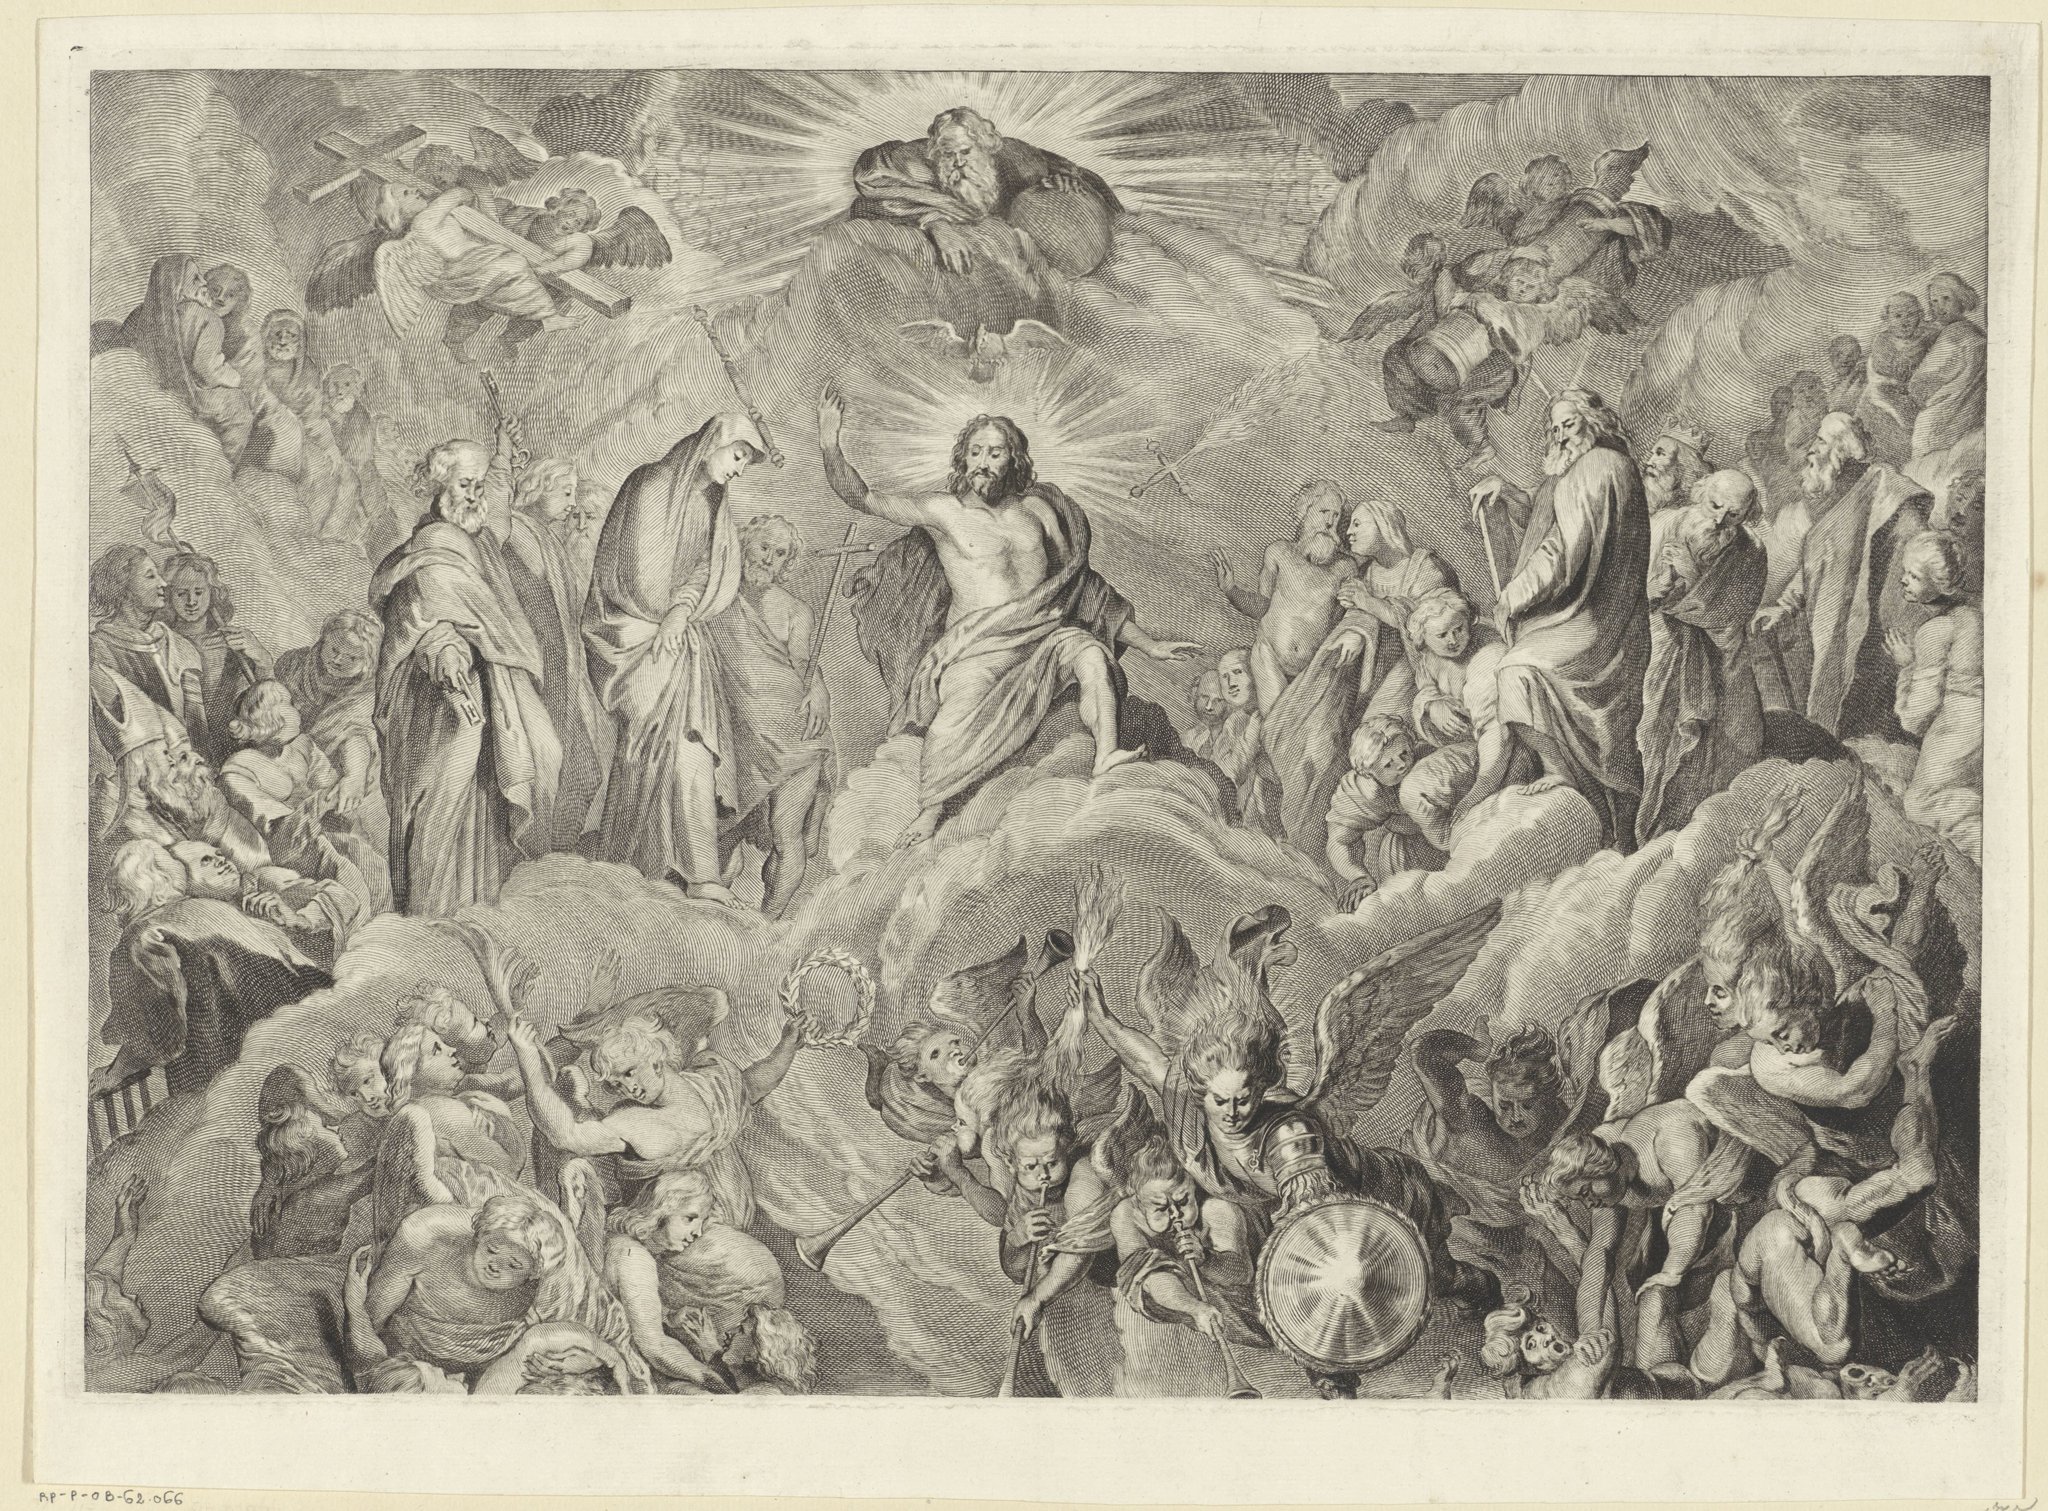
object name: print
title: Laatste Oordeel (bovenste plaat)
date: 1650-1655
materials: paper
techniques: engraving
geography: haarlem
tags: last judgement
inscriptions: collector's mark: Lugt 240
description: Christus zit tronend als rechter op een wolk in de hemel bij het laatste oordeel. Hij maakt een spreekgebaar en wordt omringd door engelen, koningen, kerkvaders en zijn apostelen. Boven hem vliegt de duif van de Heilige Geest en ligt God met de wereldbol op een wolk.